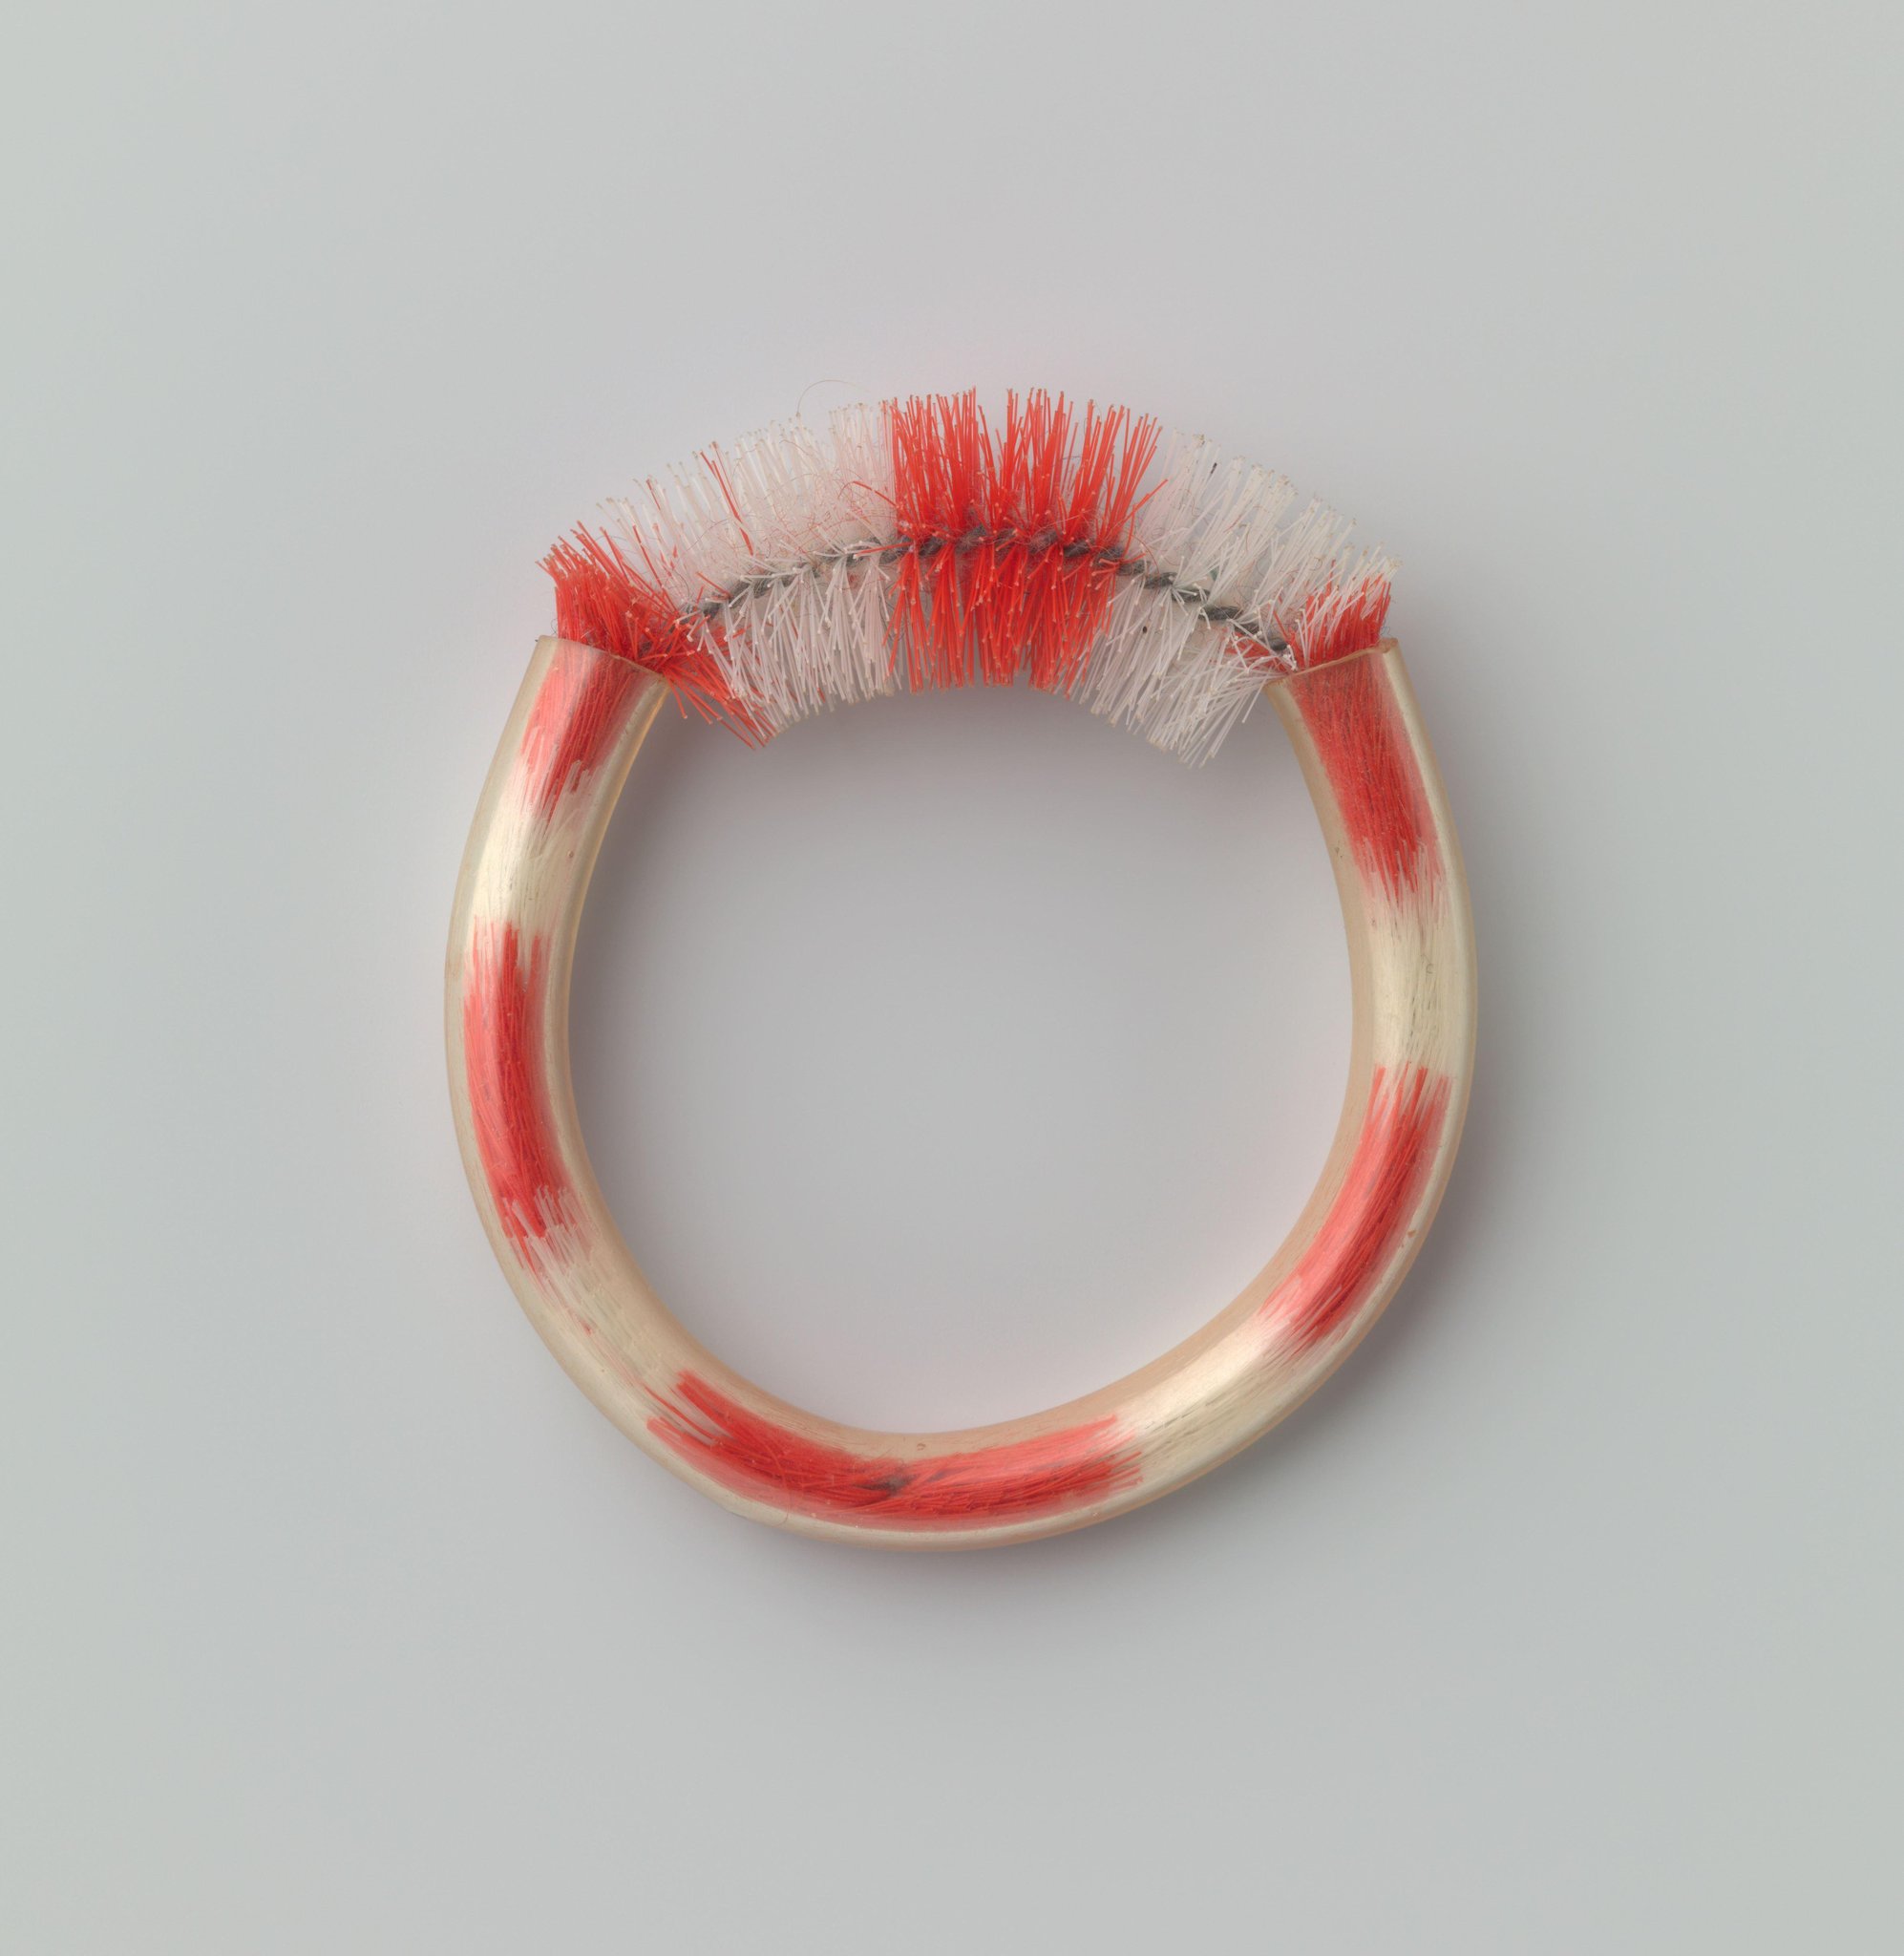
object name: bracelet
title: Armband met flessenborstel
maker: marga staartjes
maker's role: designer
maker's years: 1953-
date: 1969-1980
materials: metal, plastic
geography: netherlands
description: Armband van een doorzichtige buis van plastic waarin een roodwitte flessenborstel is geschoven.